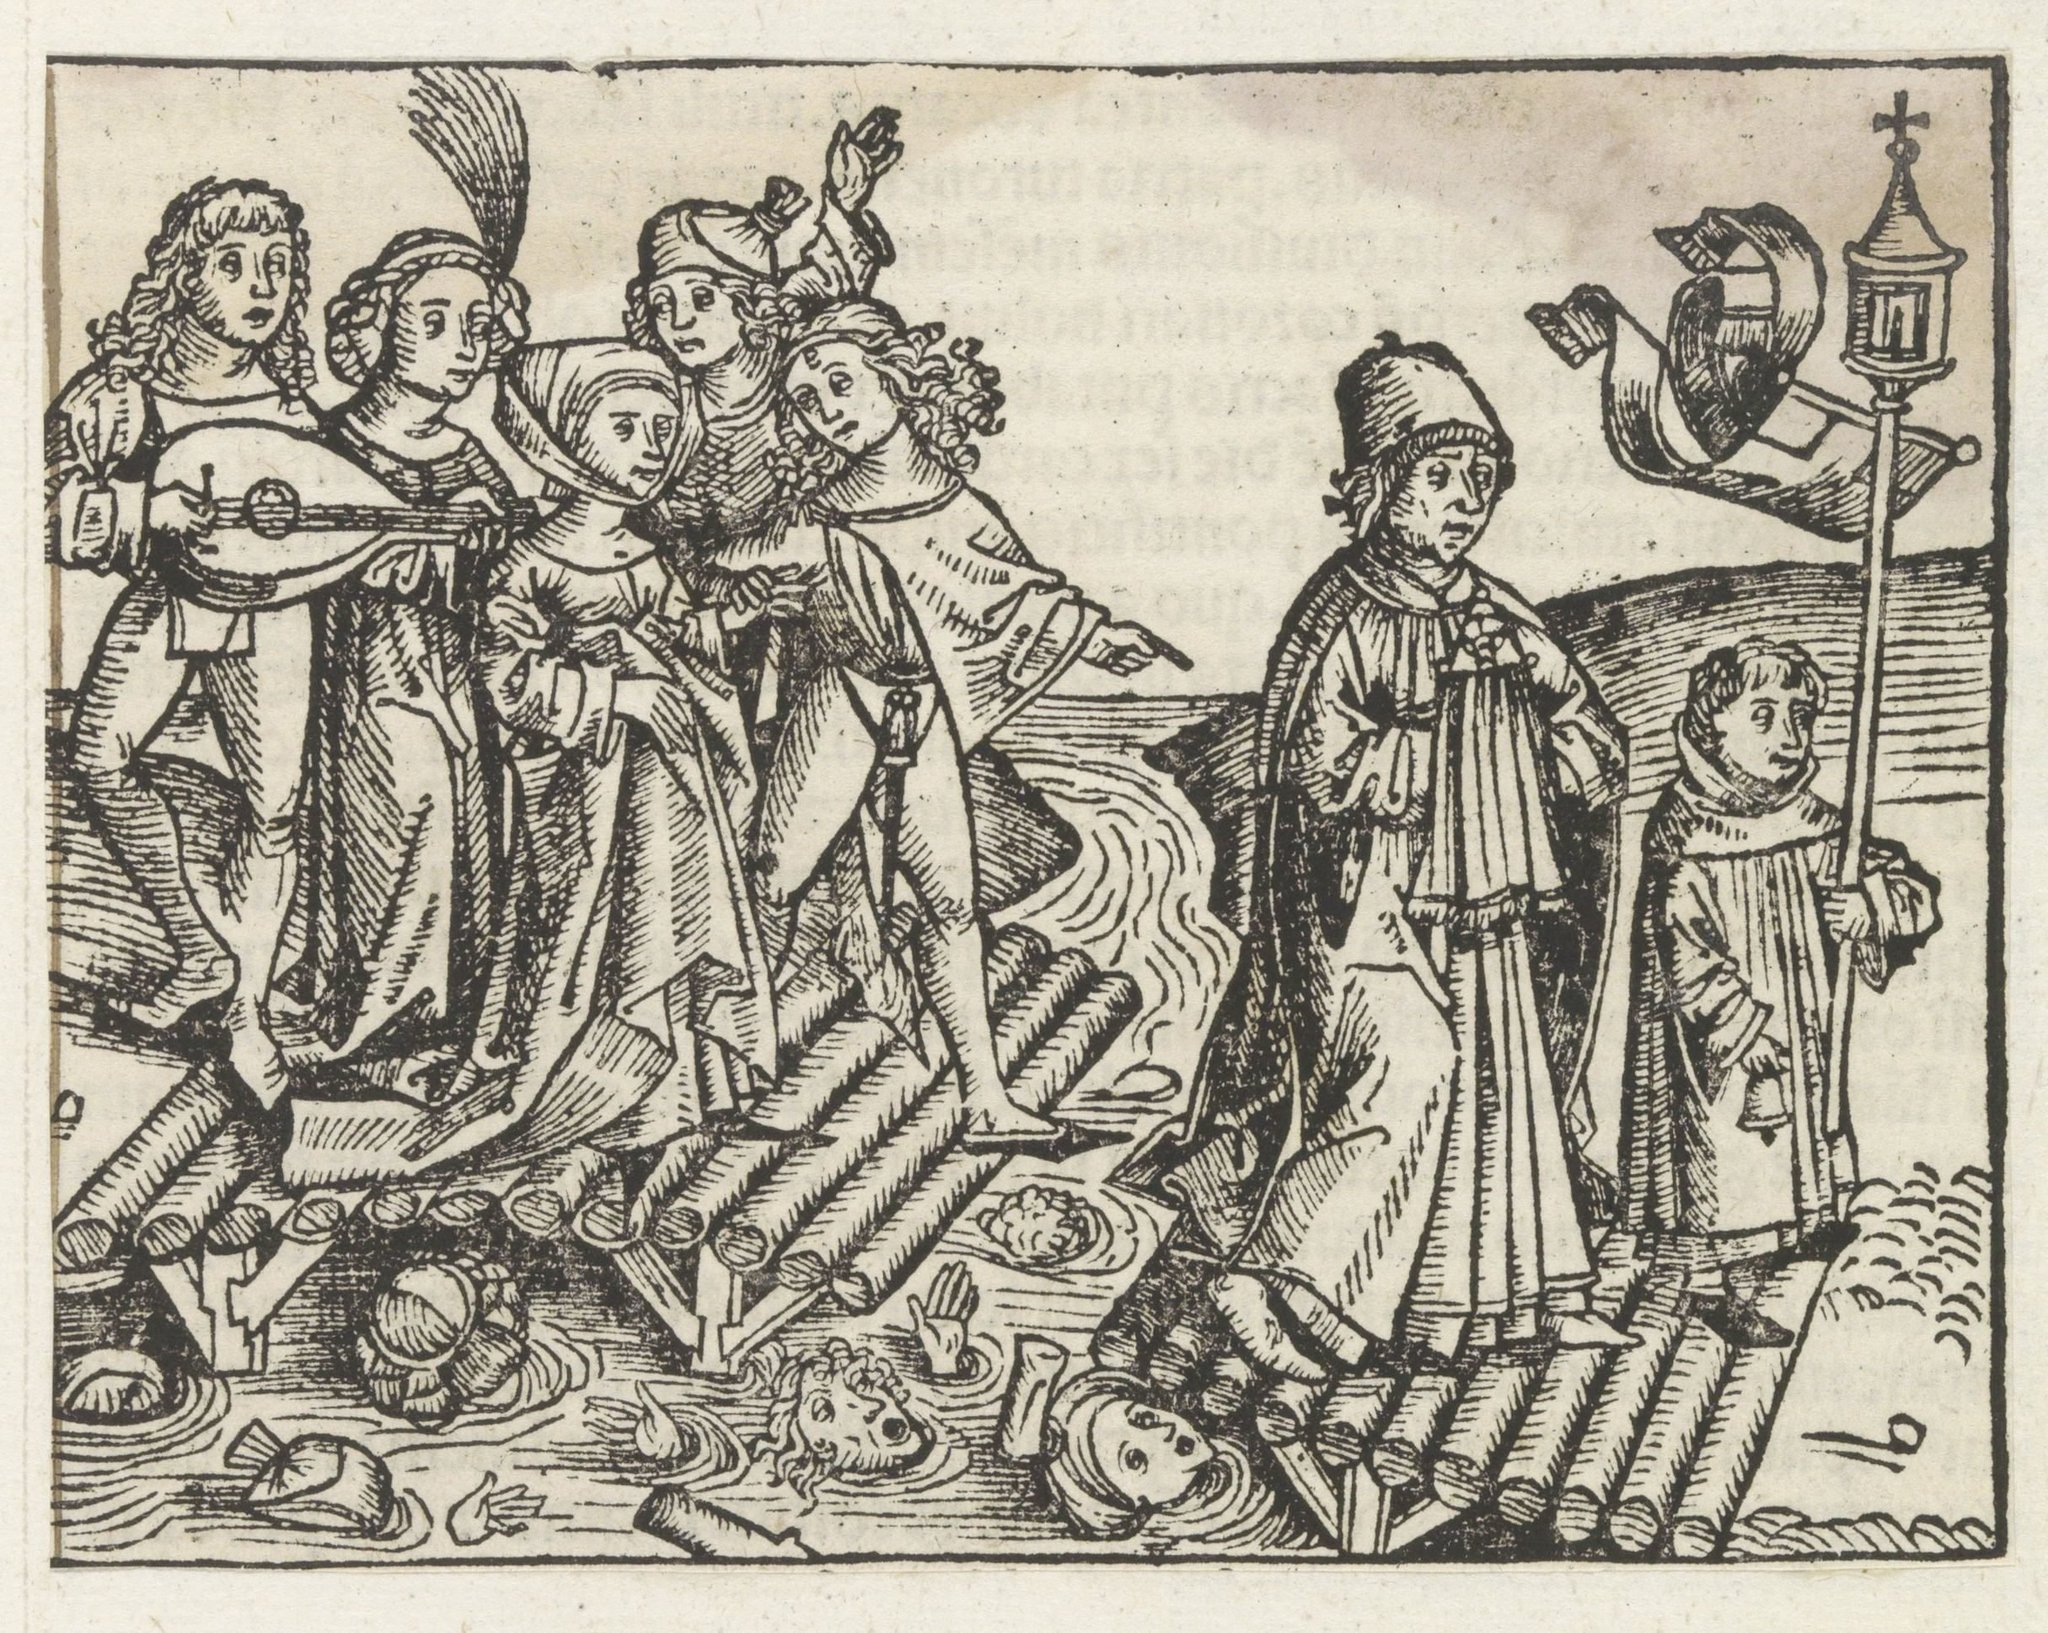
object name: book illustration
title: Inzakken van een brug bij Utrecht of Maastricht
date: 1493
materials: paper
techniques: letterpress printing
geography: nuremberg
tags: group dancing, drowning (violent death ~ water)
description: Het inzakken van een brug. De daarop lopende personen verdrinken, omdat zij niet ophielden met dansen terwijl het Heilige Sacrament voorbijgedragen werd. De tekst in het Liber Chronicarum noemt Utrecht, maar ook dat de dansers in de Maas vielen. De prent maakt deel uit van een album.